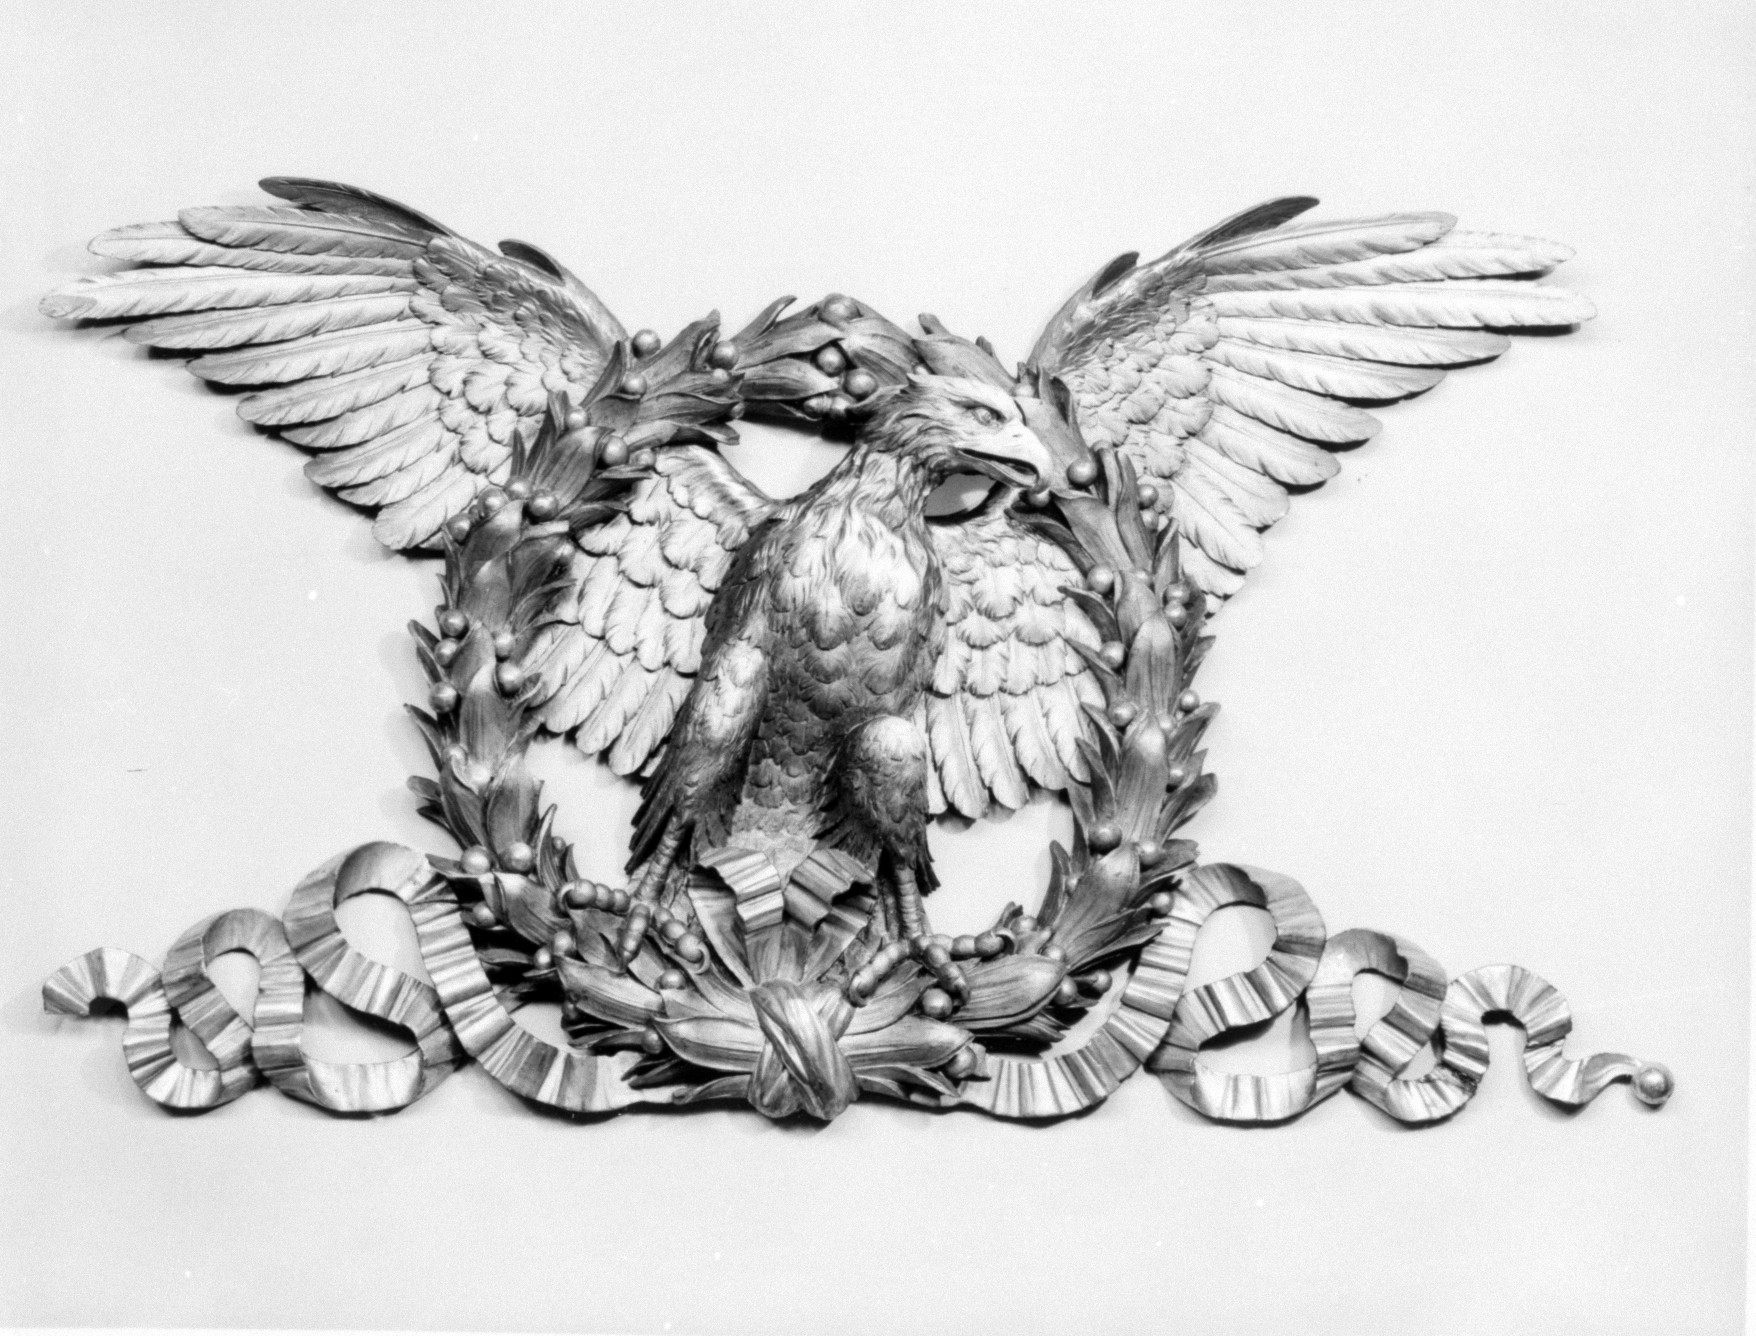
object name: overdoor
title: Overdoor with Eagle and Laurel Wreath (one of a pair)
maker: giocondo (giuseppe) albertolli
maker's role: designer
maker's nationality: italian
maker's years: 1742-1839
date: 1790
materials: wood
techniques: carving, gilding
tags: eagles,garlands